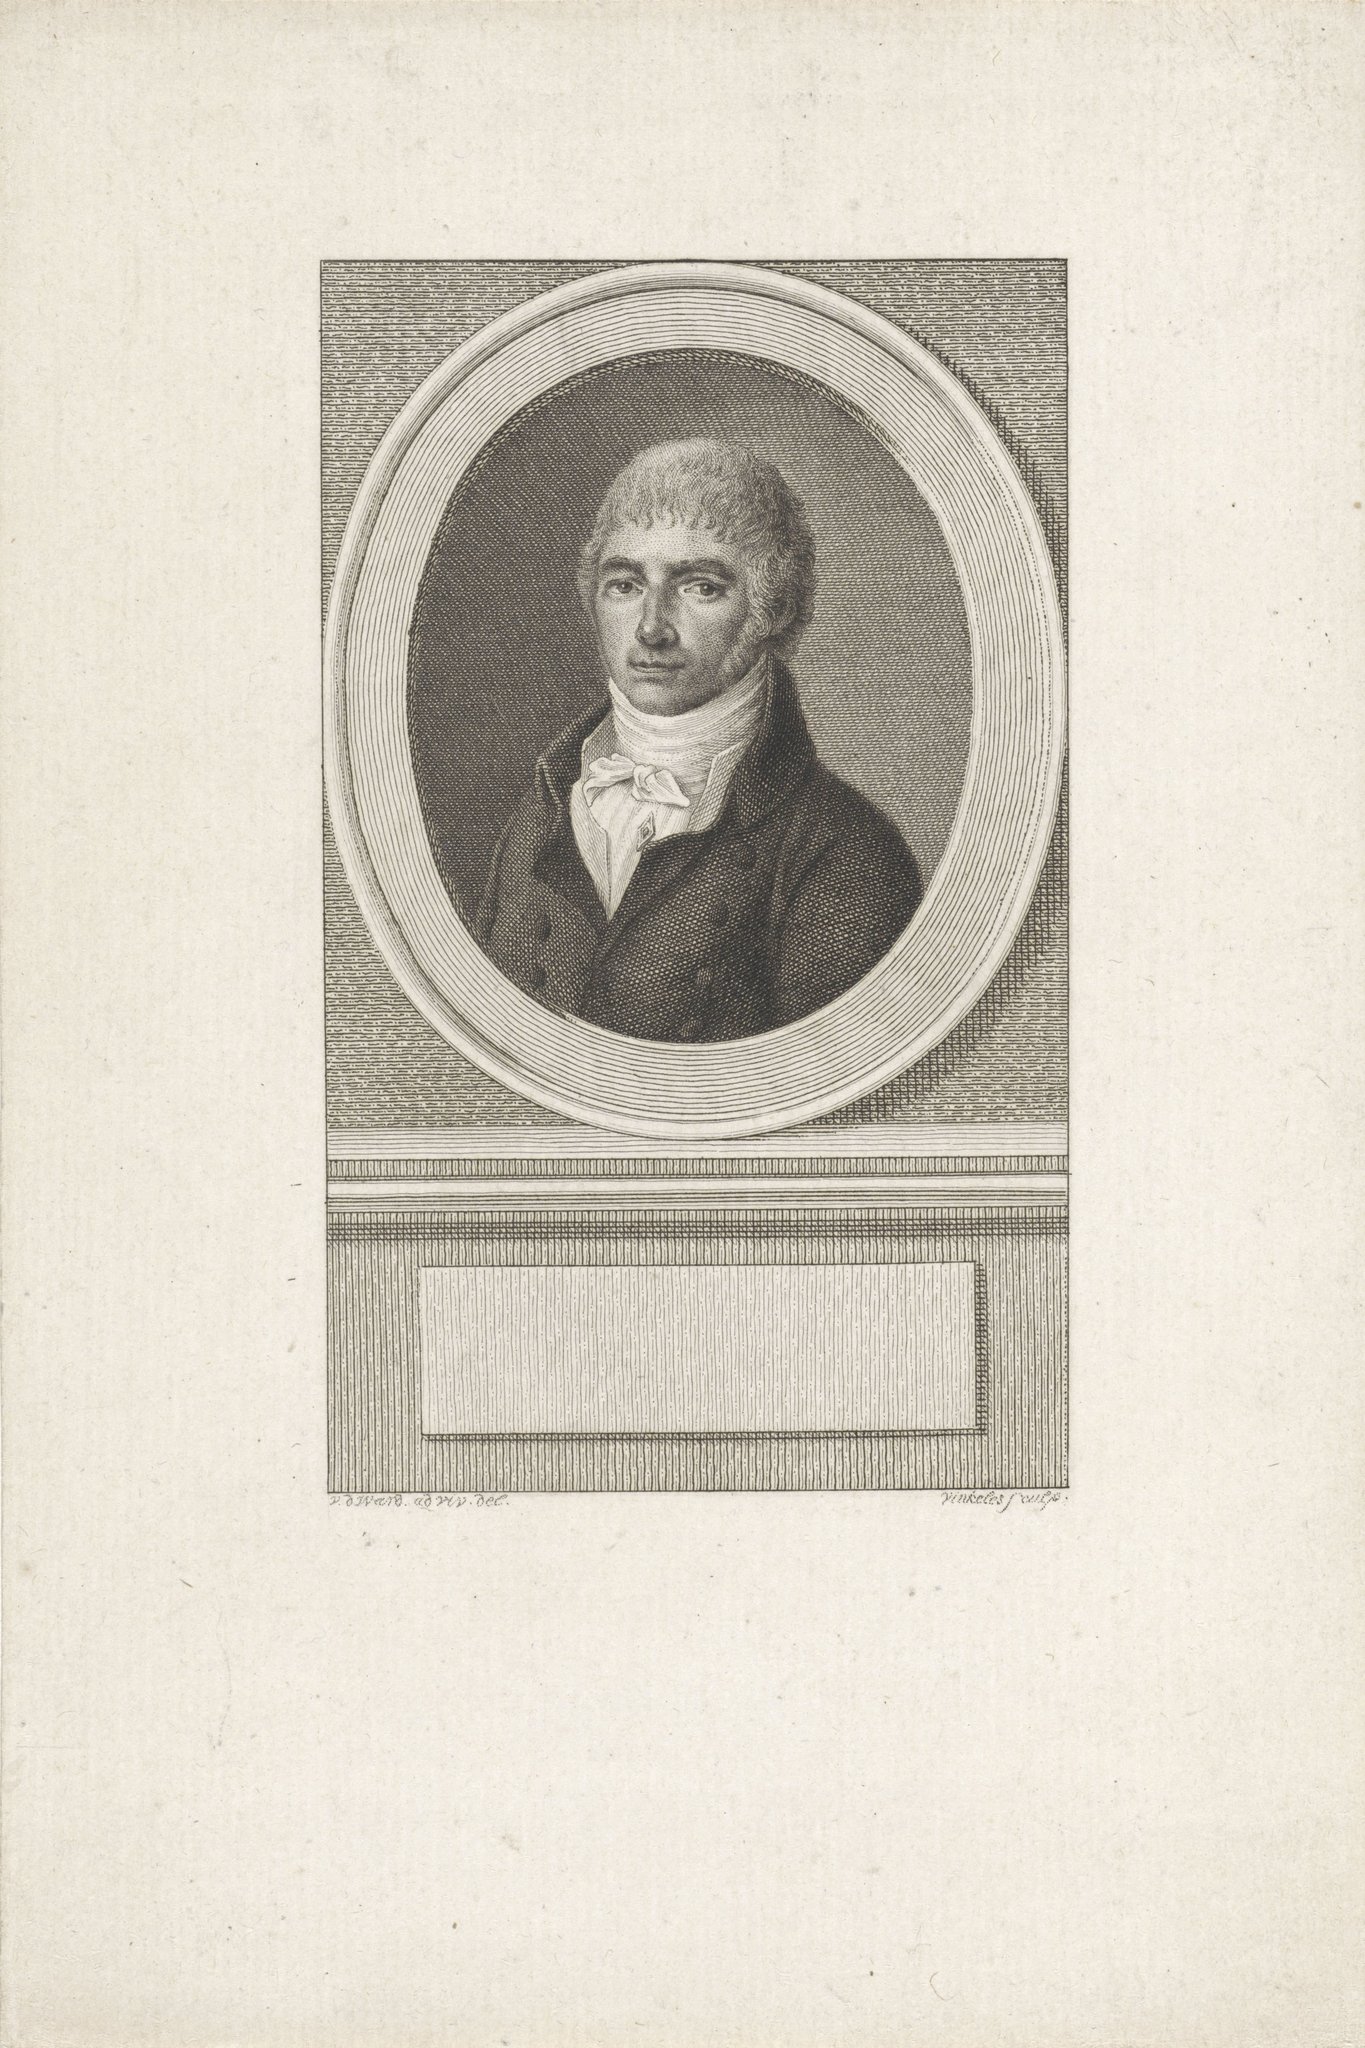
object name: print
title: Portret van de Nederlandse dichter Cornelis Loots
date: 1786-1809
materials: paper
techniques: etching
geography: amsterdam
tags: amsterdam, cornelis loots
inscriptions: collector's mark: Lugt 2228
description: Latere staat prent ook gebruikt als boekillustratie in: Wagenaar, Jan. Vaderlandsche historie, (...) ten vervolge van Wagenaars Vaderlandsche historie. Dl. 1-43. Amsterdam: Johannes Allart, 1786-1809.